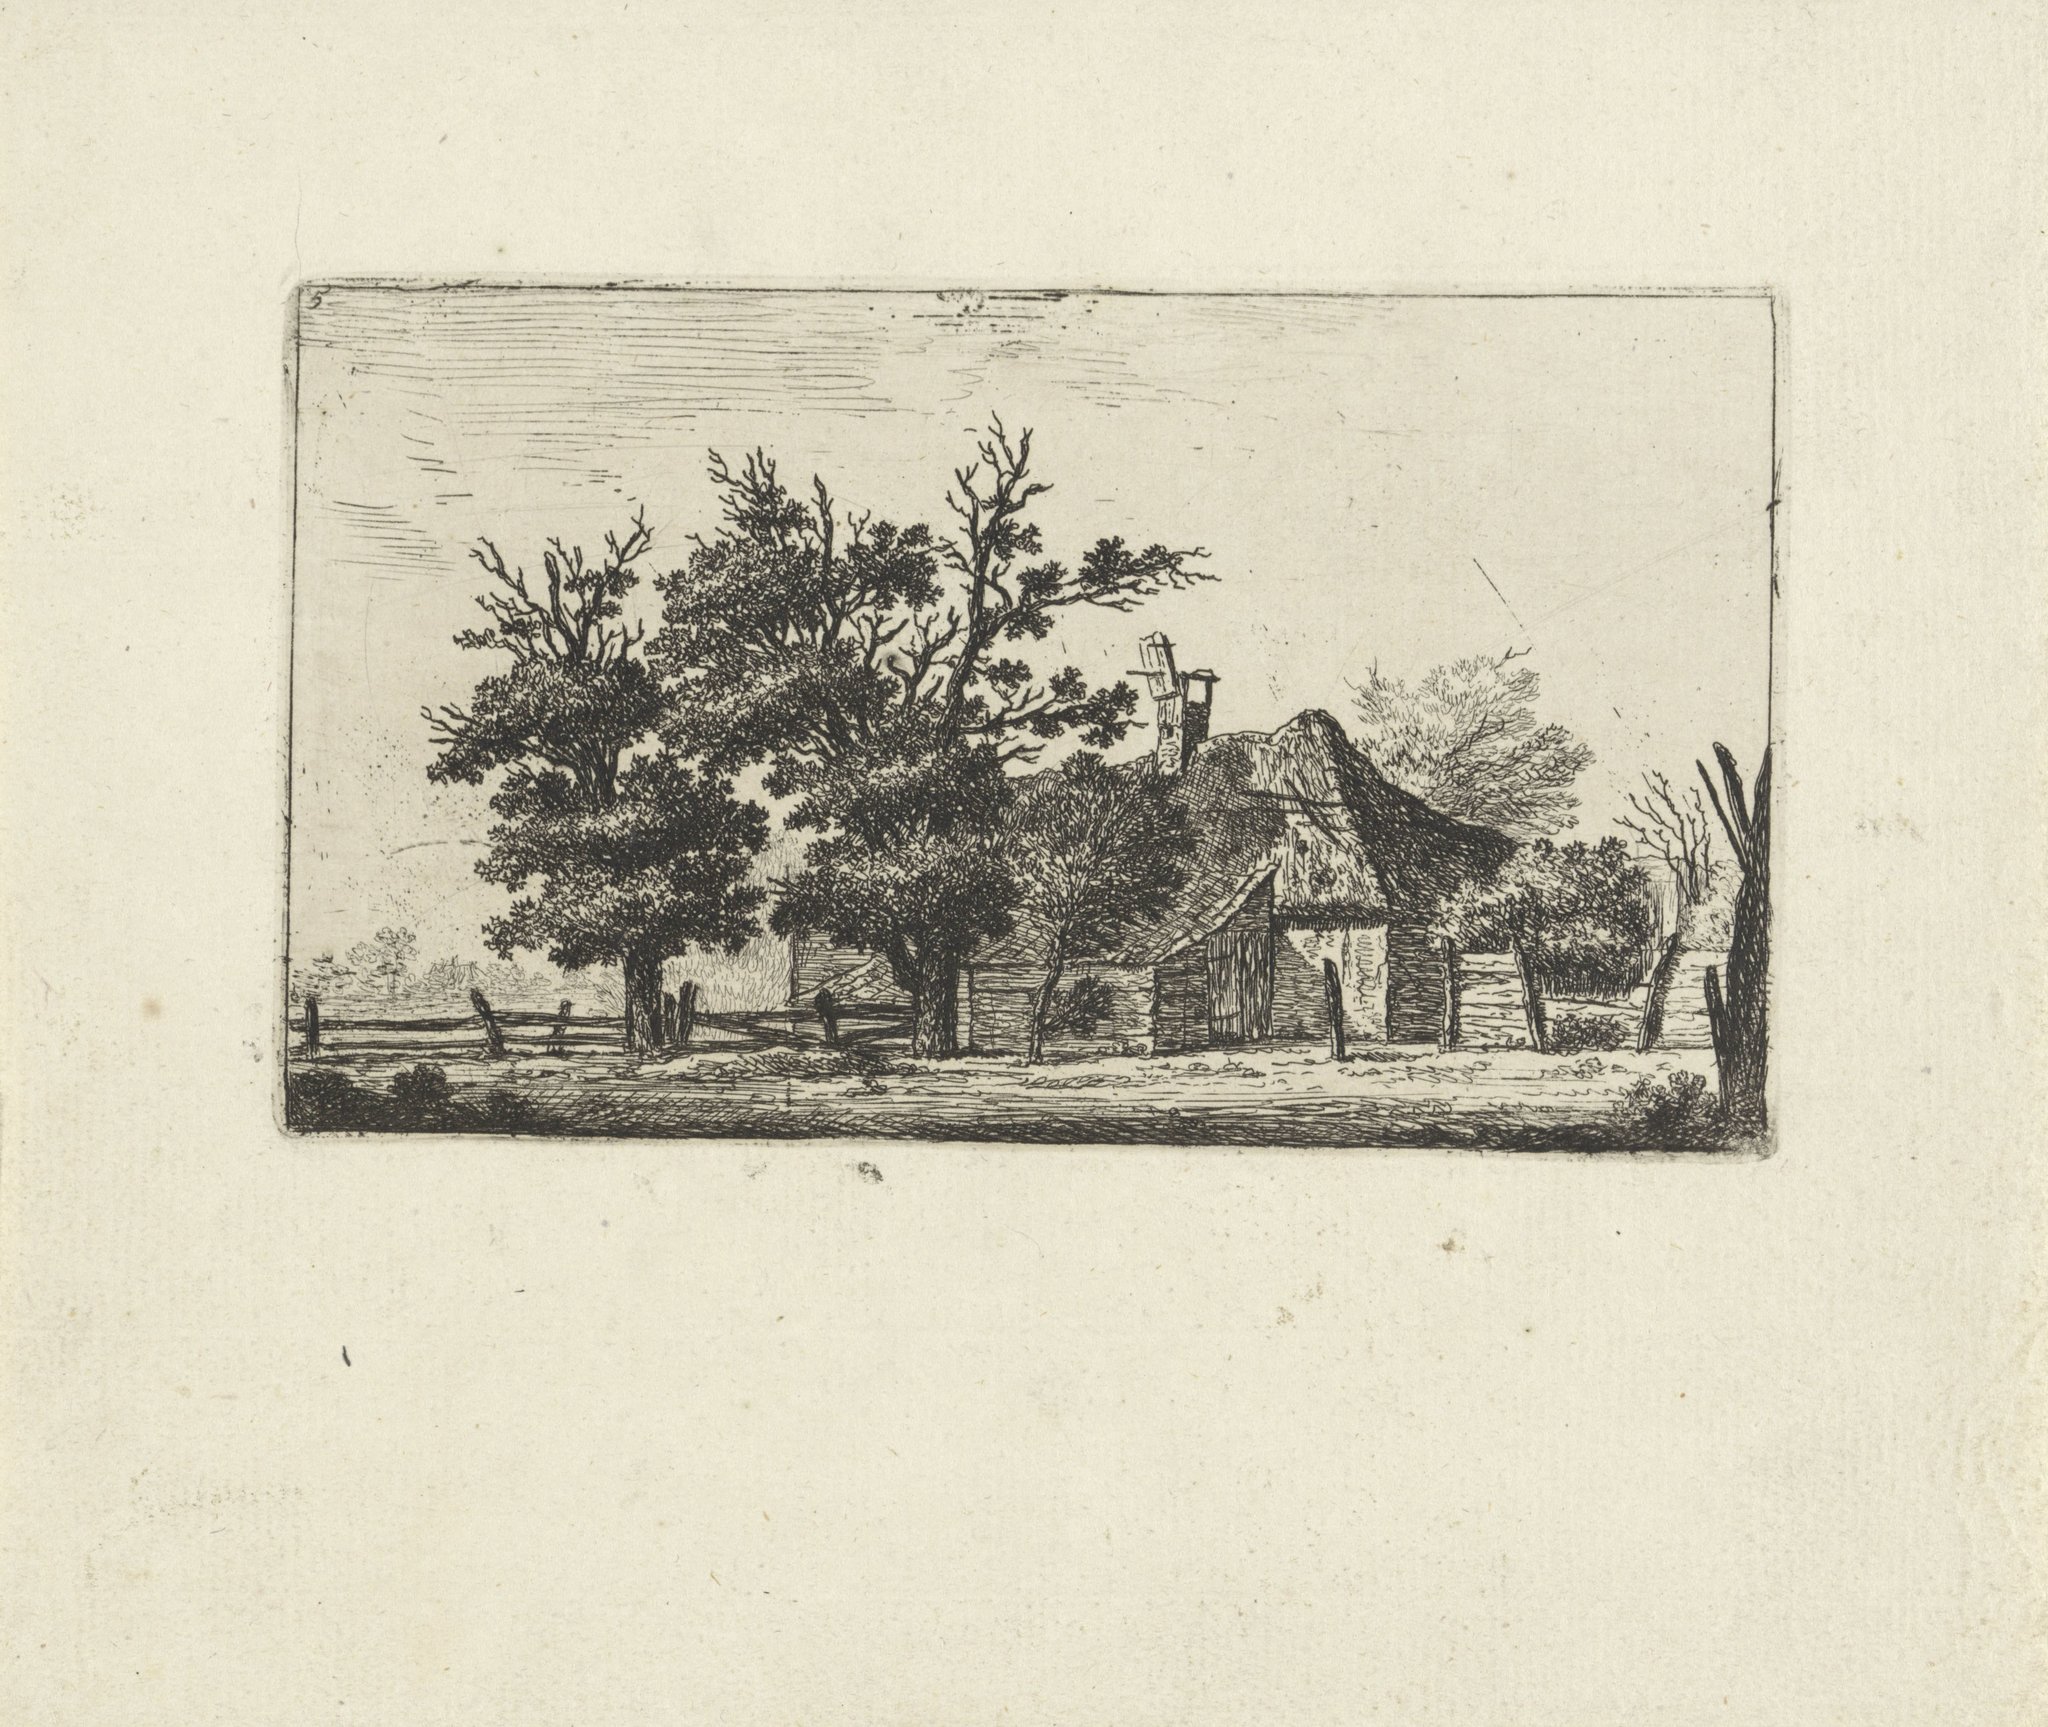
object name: print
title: Landschappen met woningen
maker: hendrik schwegman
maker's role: draughtsman, print maker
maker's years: 1761-1816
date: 1786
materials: paper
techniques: engraving, etching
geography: haarlem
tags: farm or solitary house in landscape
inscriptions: collector's mark: Lugt 2228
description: Landschap met een boerderij tussen het geboomte. Links een laag hek en rechts een schutting.